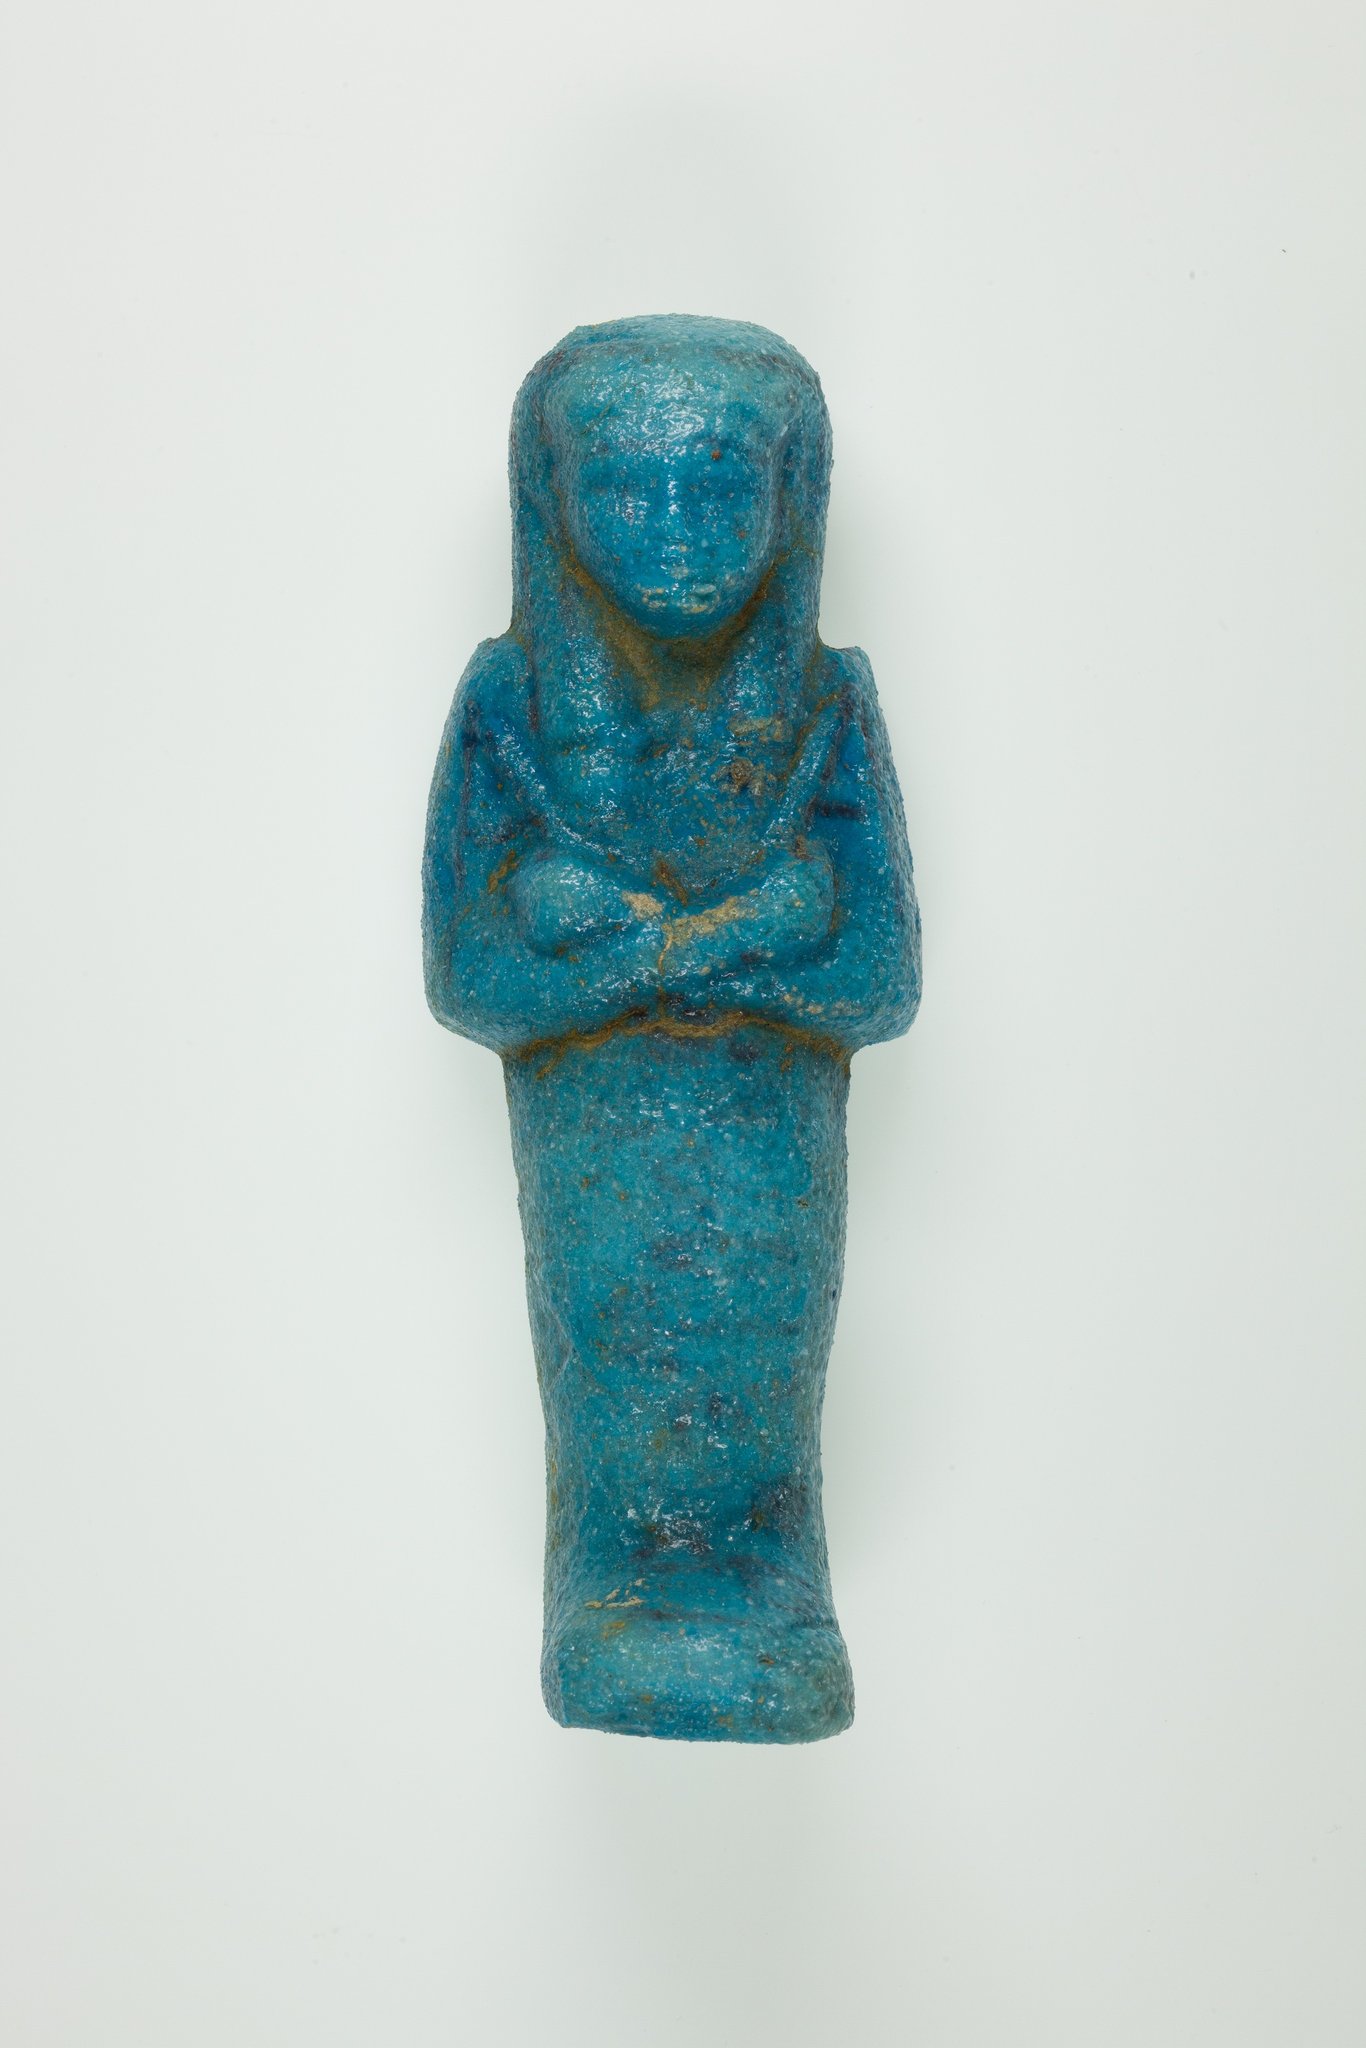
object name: worker shabti, henettawy c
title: Worker Shabti of Henettawy (C), Daughter of Isetemkheb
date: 990-970 BCE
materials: faience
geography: egypt